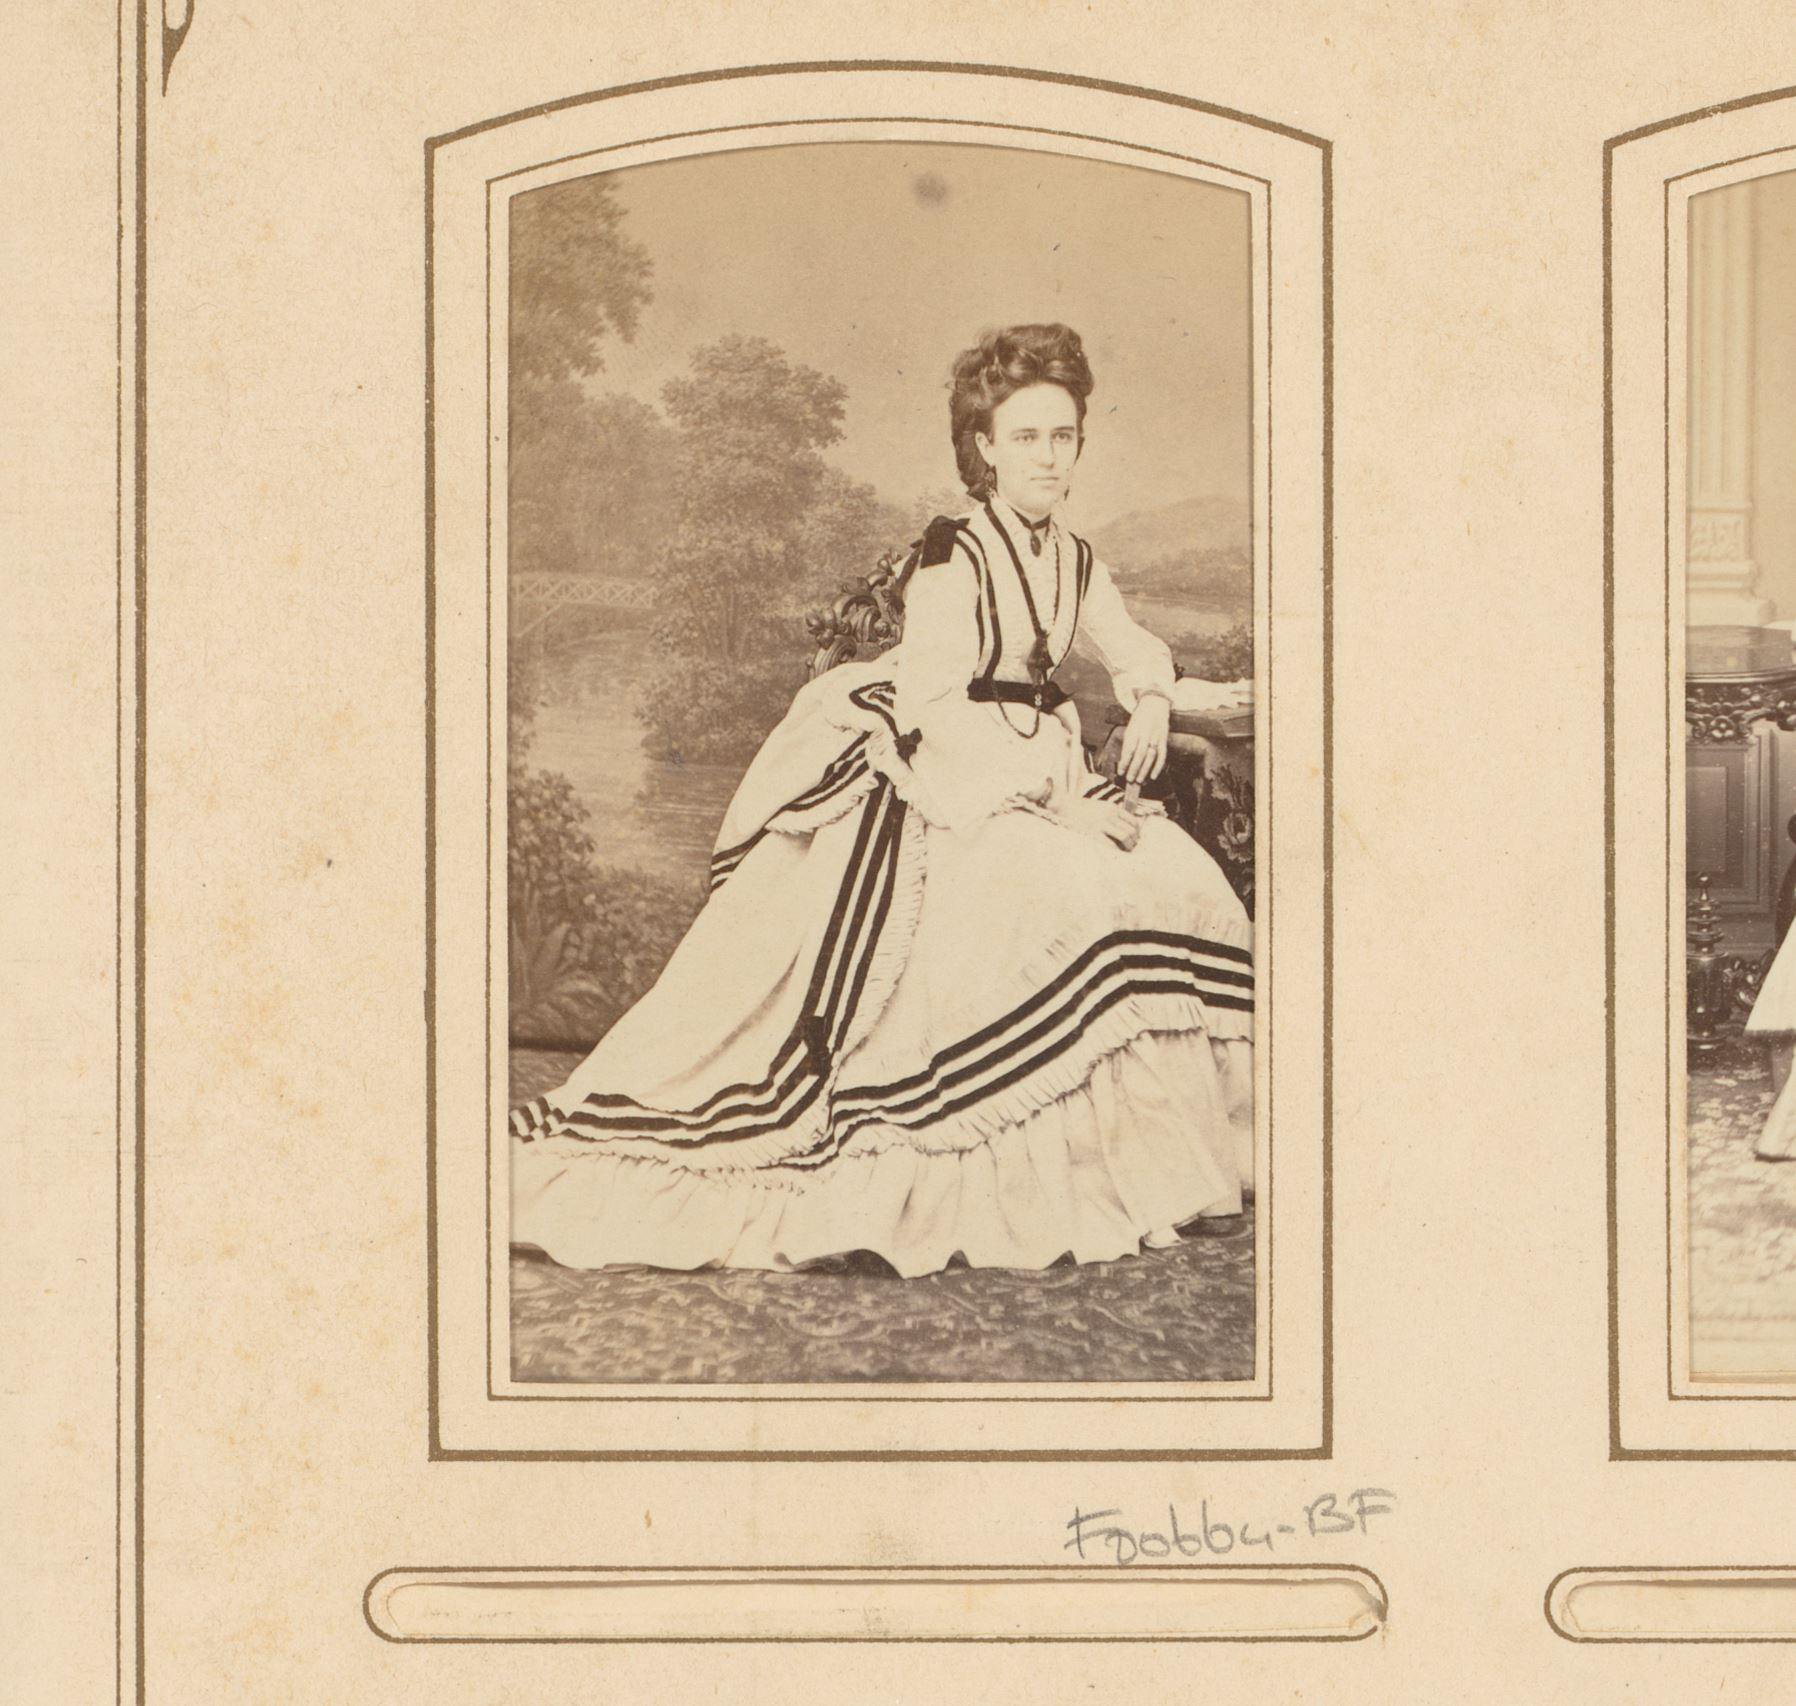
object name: album leaf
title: Portret van een vrouw in een witte jurk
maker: j.b. jasper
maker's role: fotograaf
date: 1870-1899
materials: cardboard, photographic support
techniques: albumen print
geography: surabaya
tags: historical persons - bb - woman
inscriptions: inscription: ‘J.B. Jasper/ Photograaf/ Soerabaya’